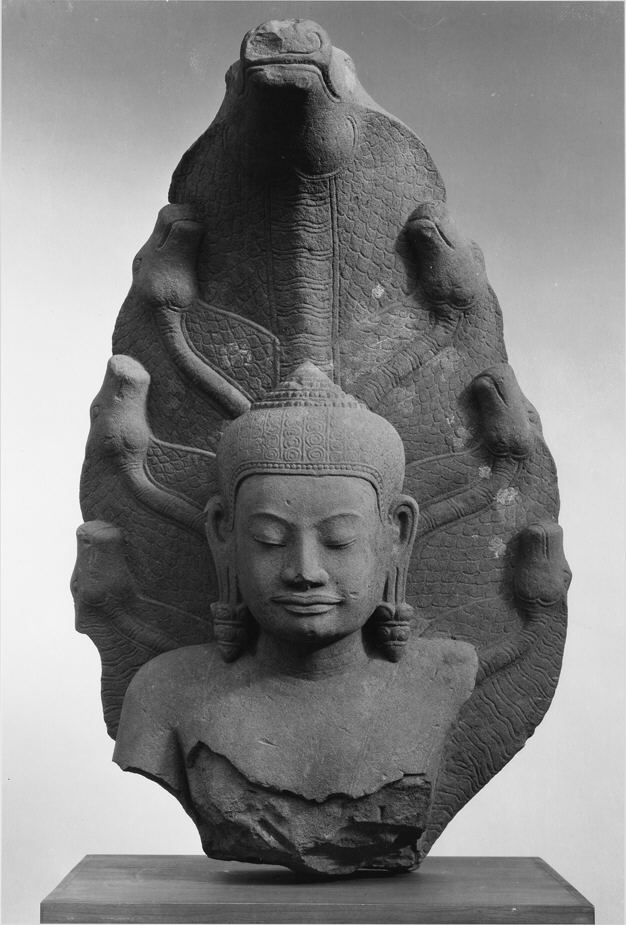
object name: sculpture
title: Buddha Protected by a Seven-headed Naga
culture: cambodian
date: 1167-1233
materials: stone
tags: snakes,buddhism,buddha